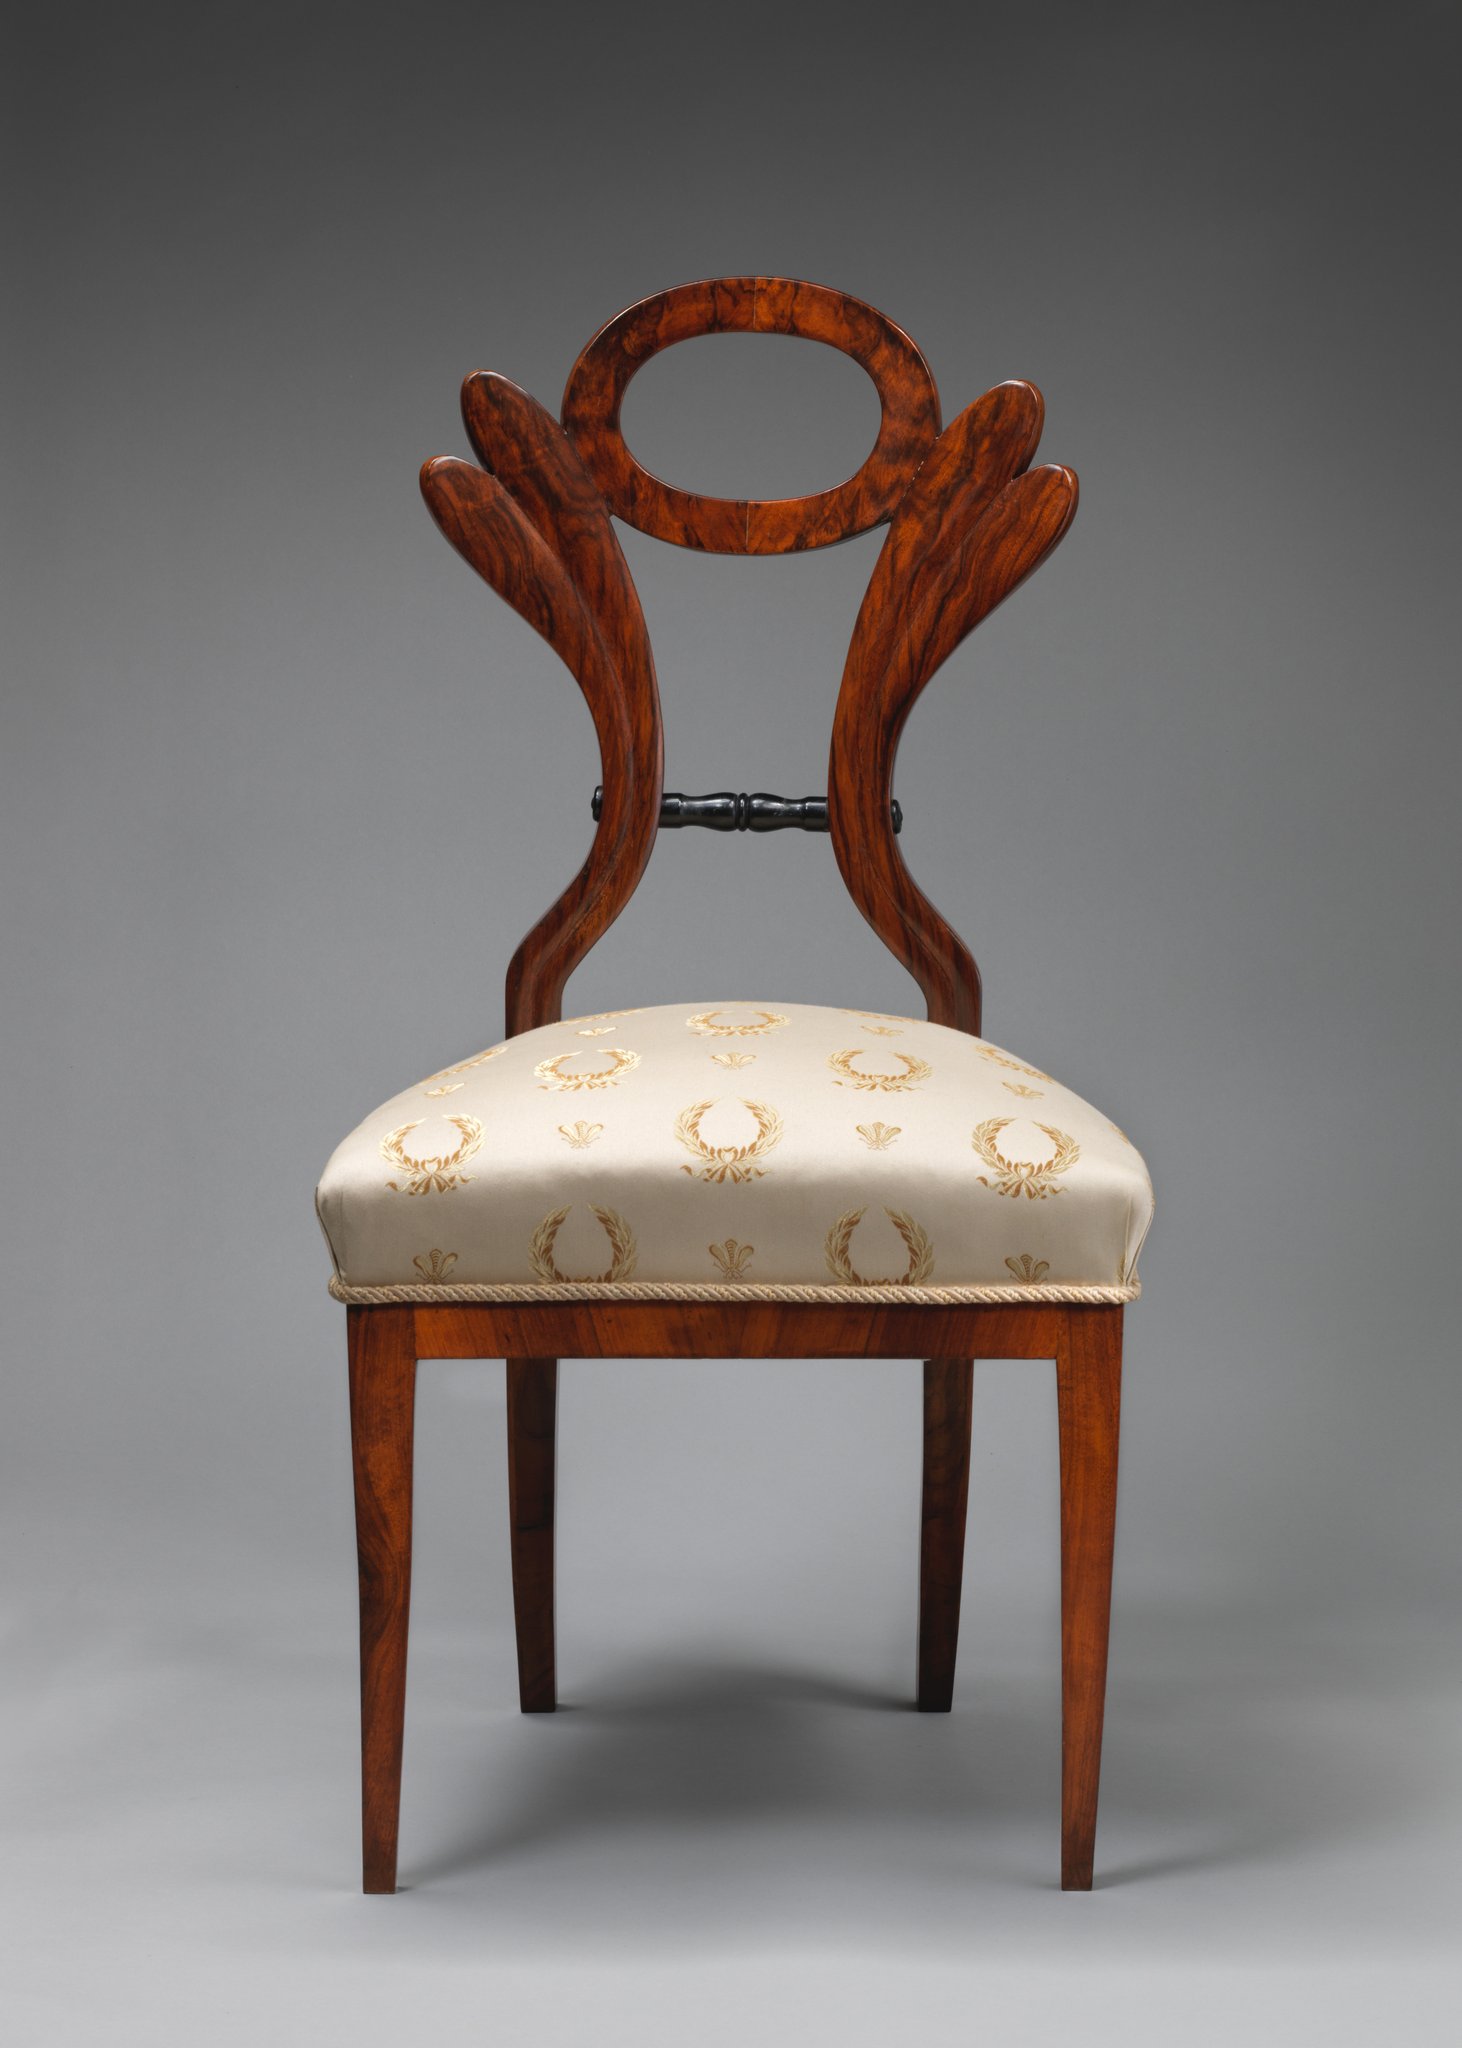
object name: chair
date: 1830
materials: wood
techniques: veneering